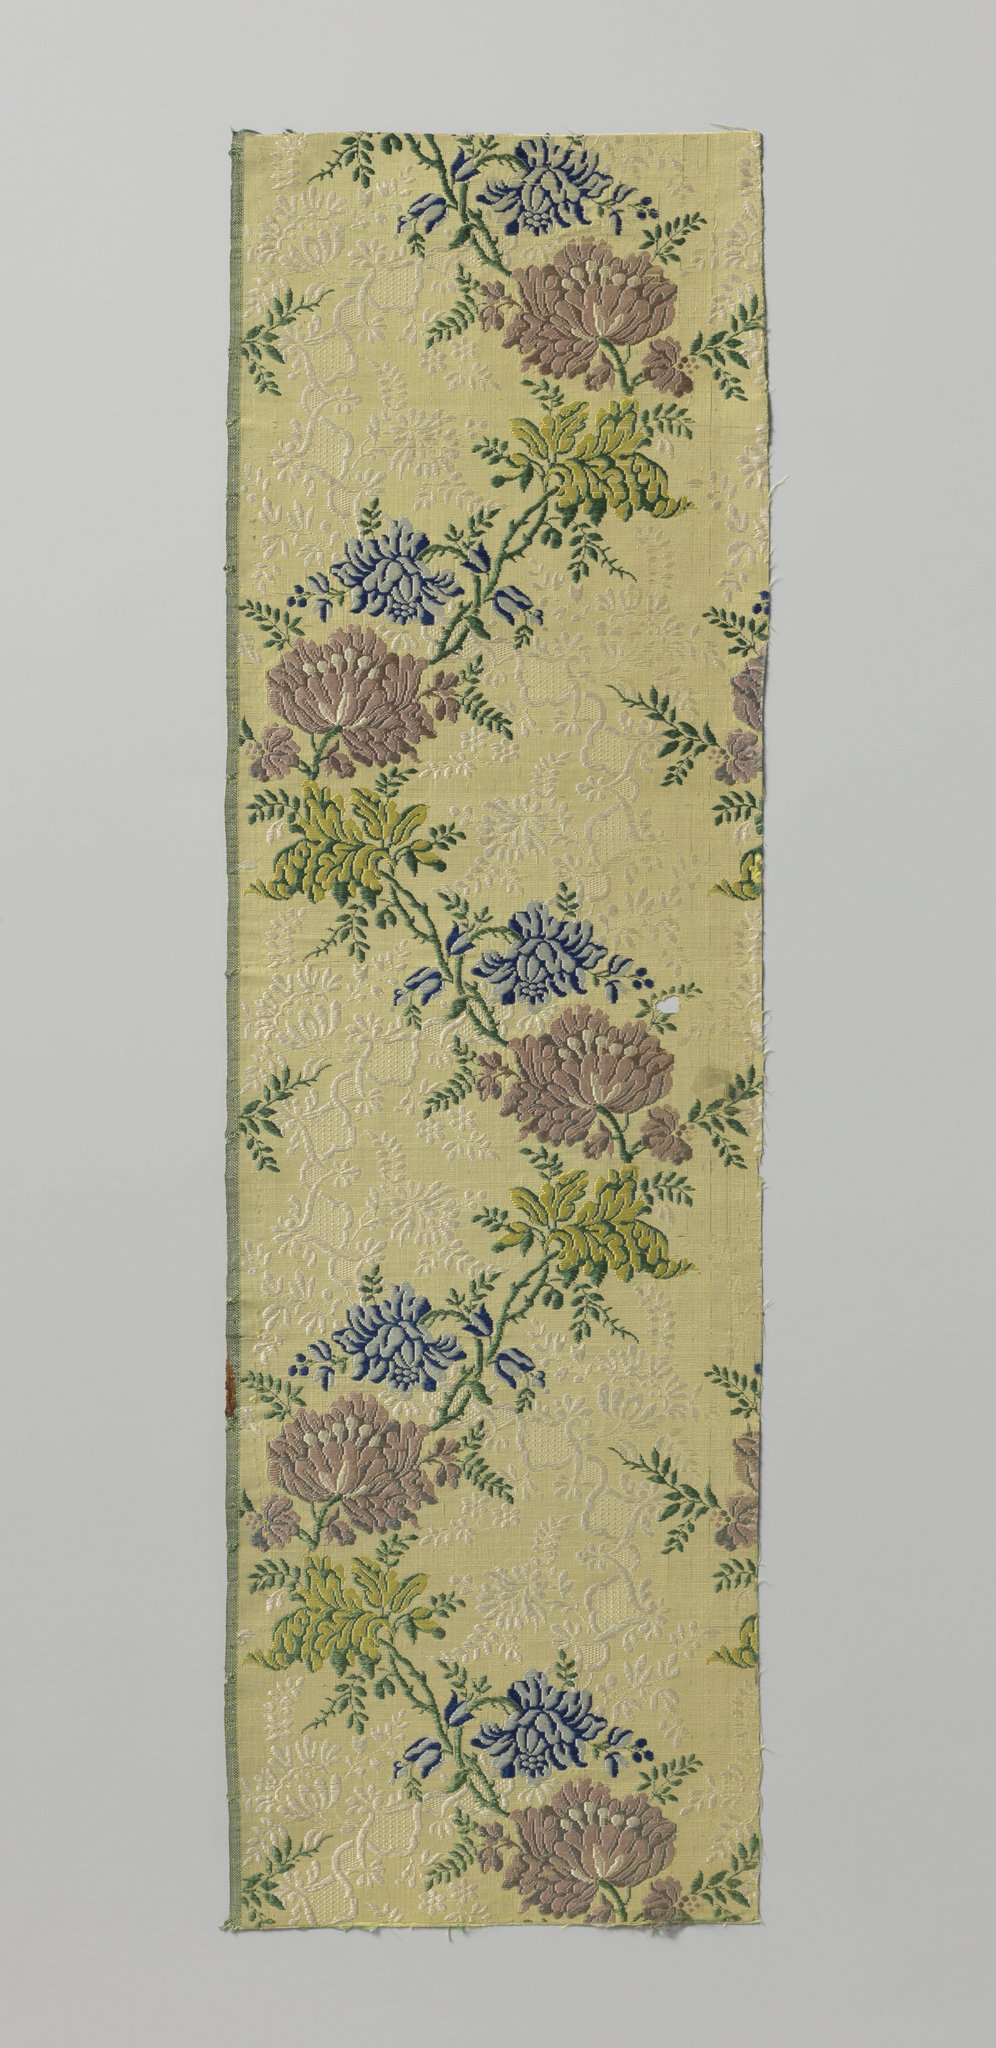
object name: fragment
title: Fragment veelkleurige gebrocheerde zijde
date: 1700-1760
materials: silk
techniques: brocade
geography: netherlands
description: Fragment veelkleurig zijdeweefsel. Op een gele grond loopt een witte slingerende kantstrook die een slingerende strook veelkleurige bloemtakken kruist.